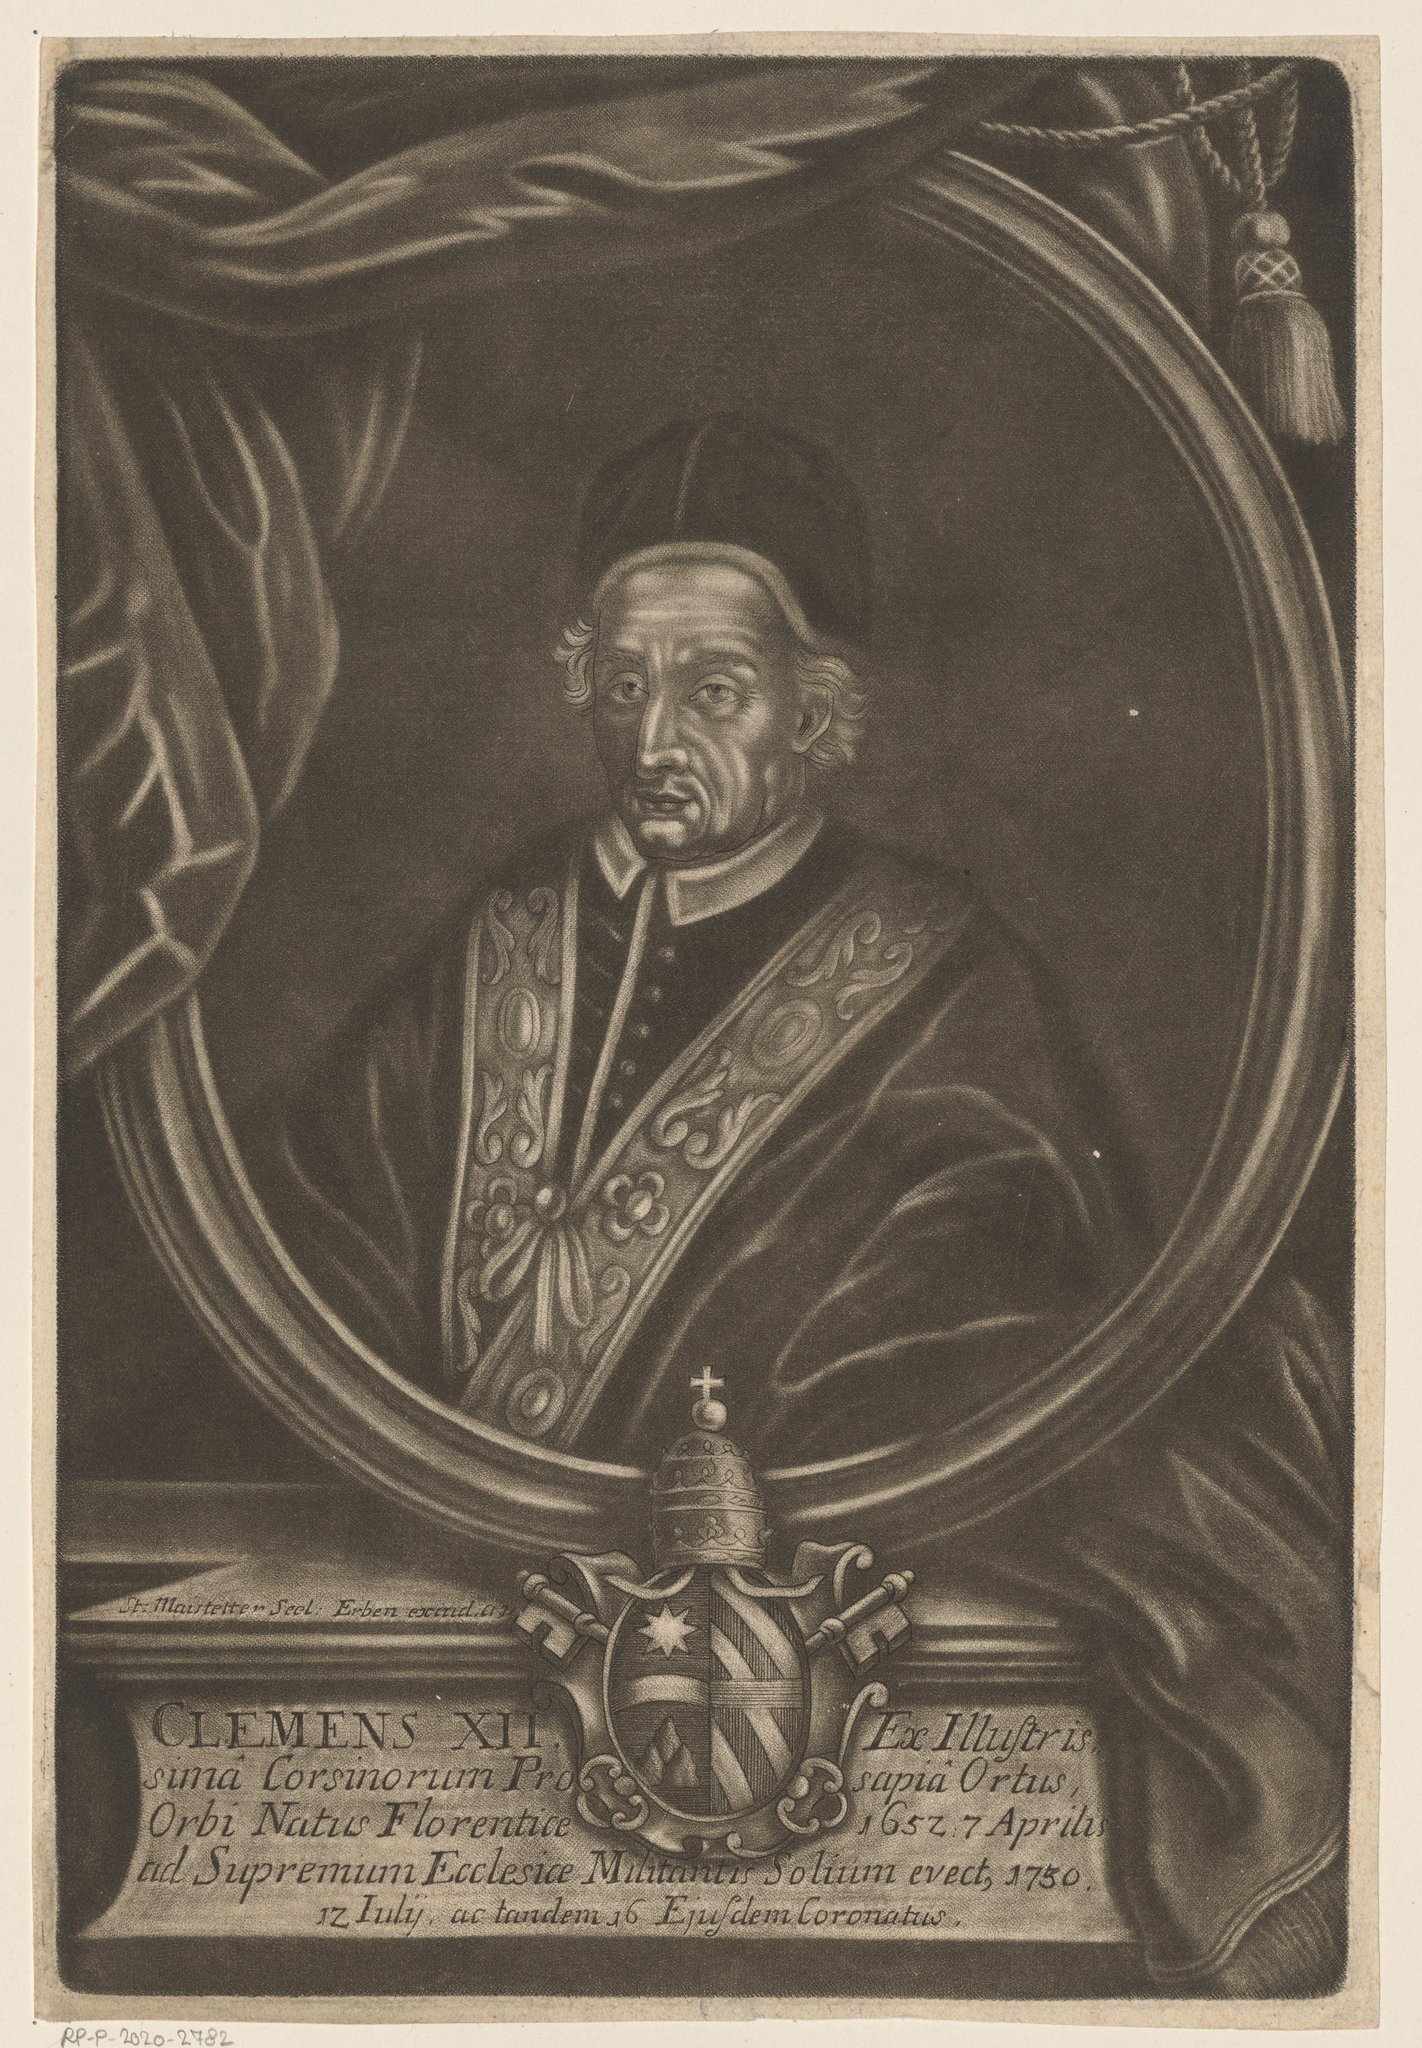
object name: print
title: Portret van paus Clemens XII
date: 1730-1740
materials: paper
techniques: etching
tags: rome, clemens xii, historical persons, pope, armorial bearing, heraldry